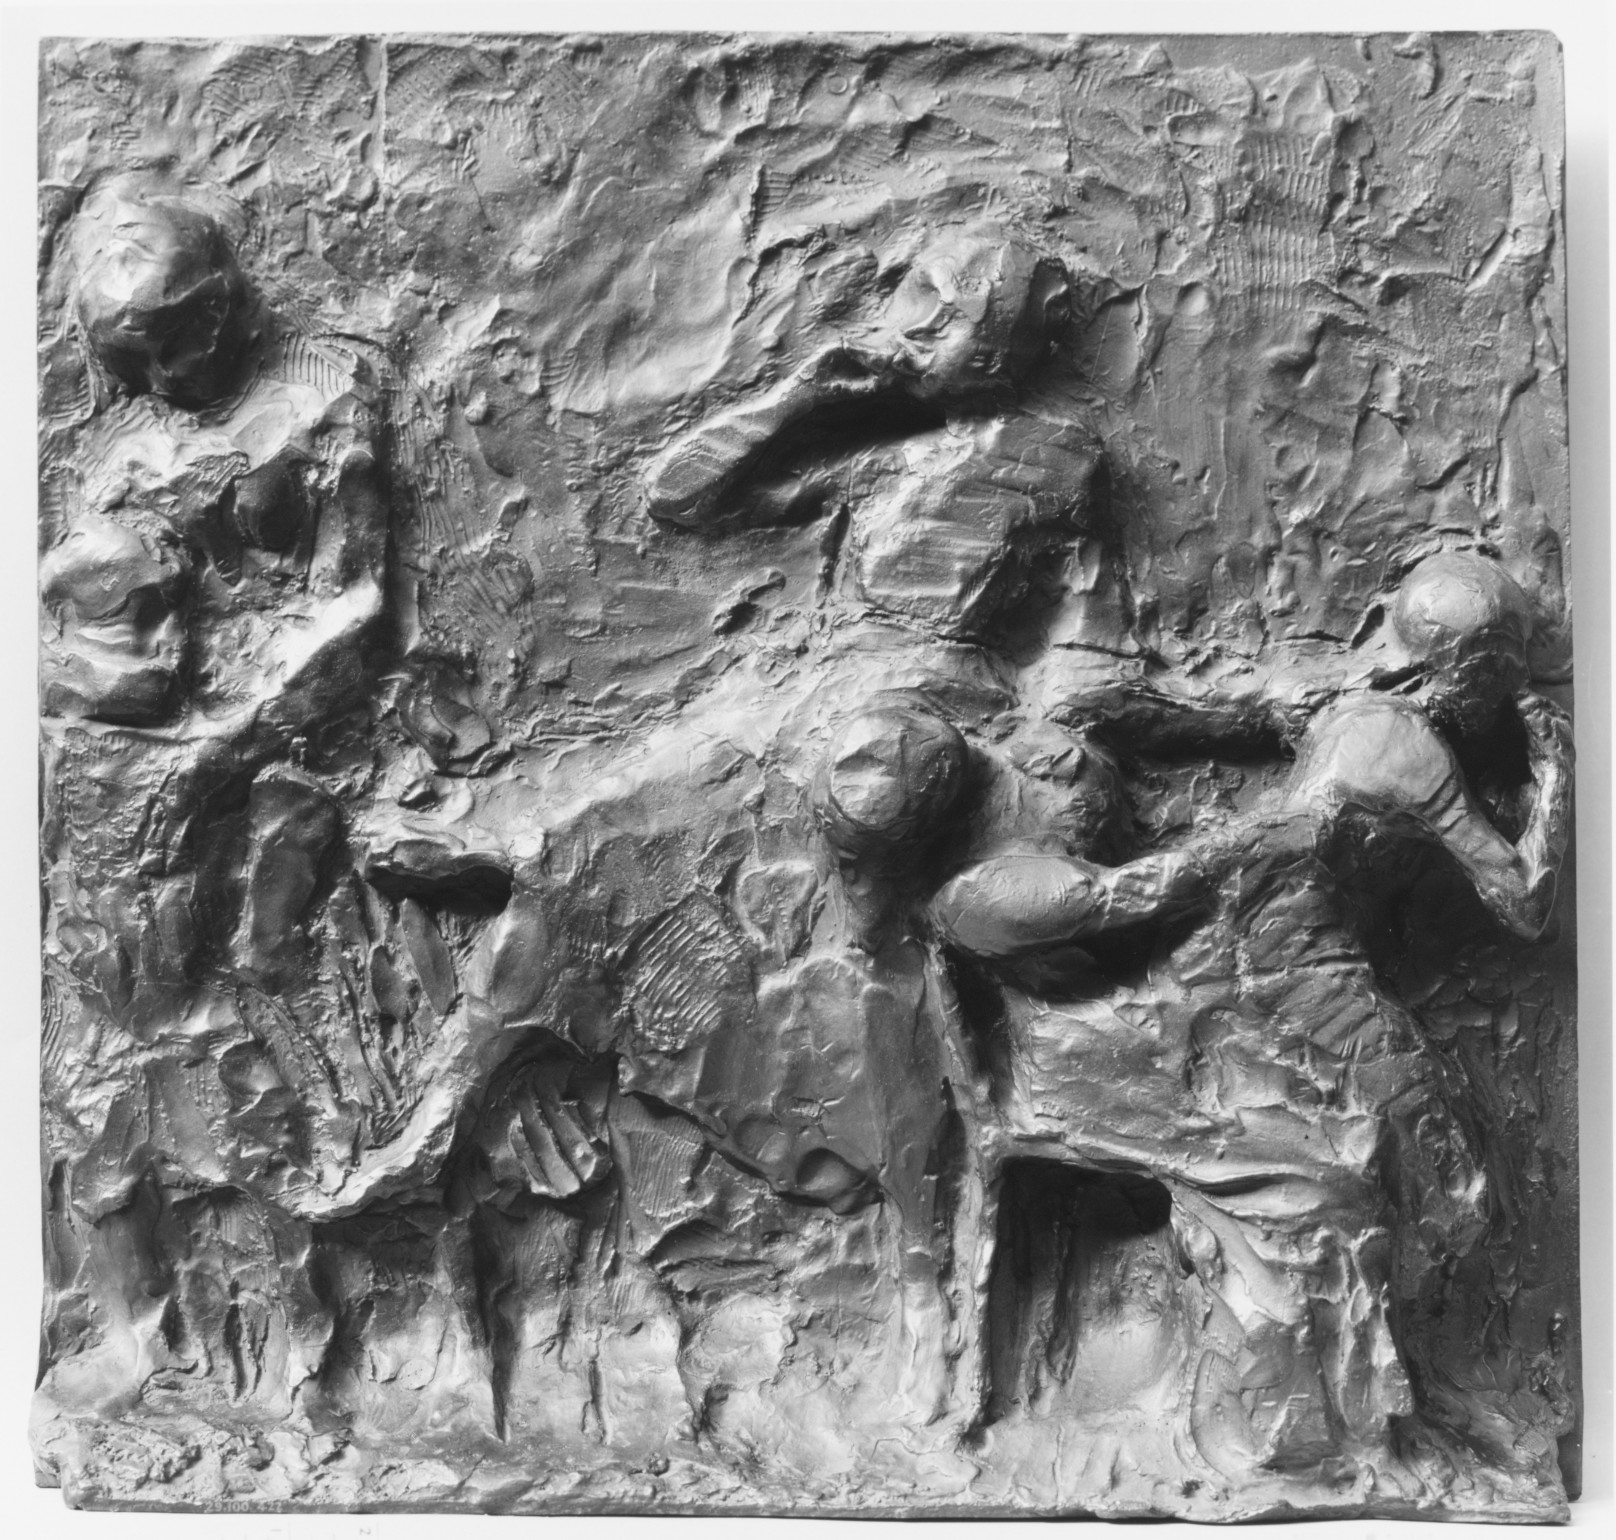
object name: relief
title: The Apple Pickers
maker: edgar degas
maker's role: artist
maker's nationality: french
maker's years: 1834-1917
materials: bronze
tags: human figures